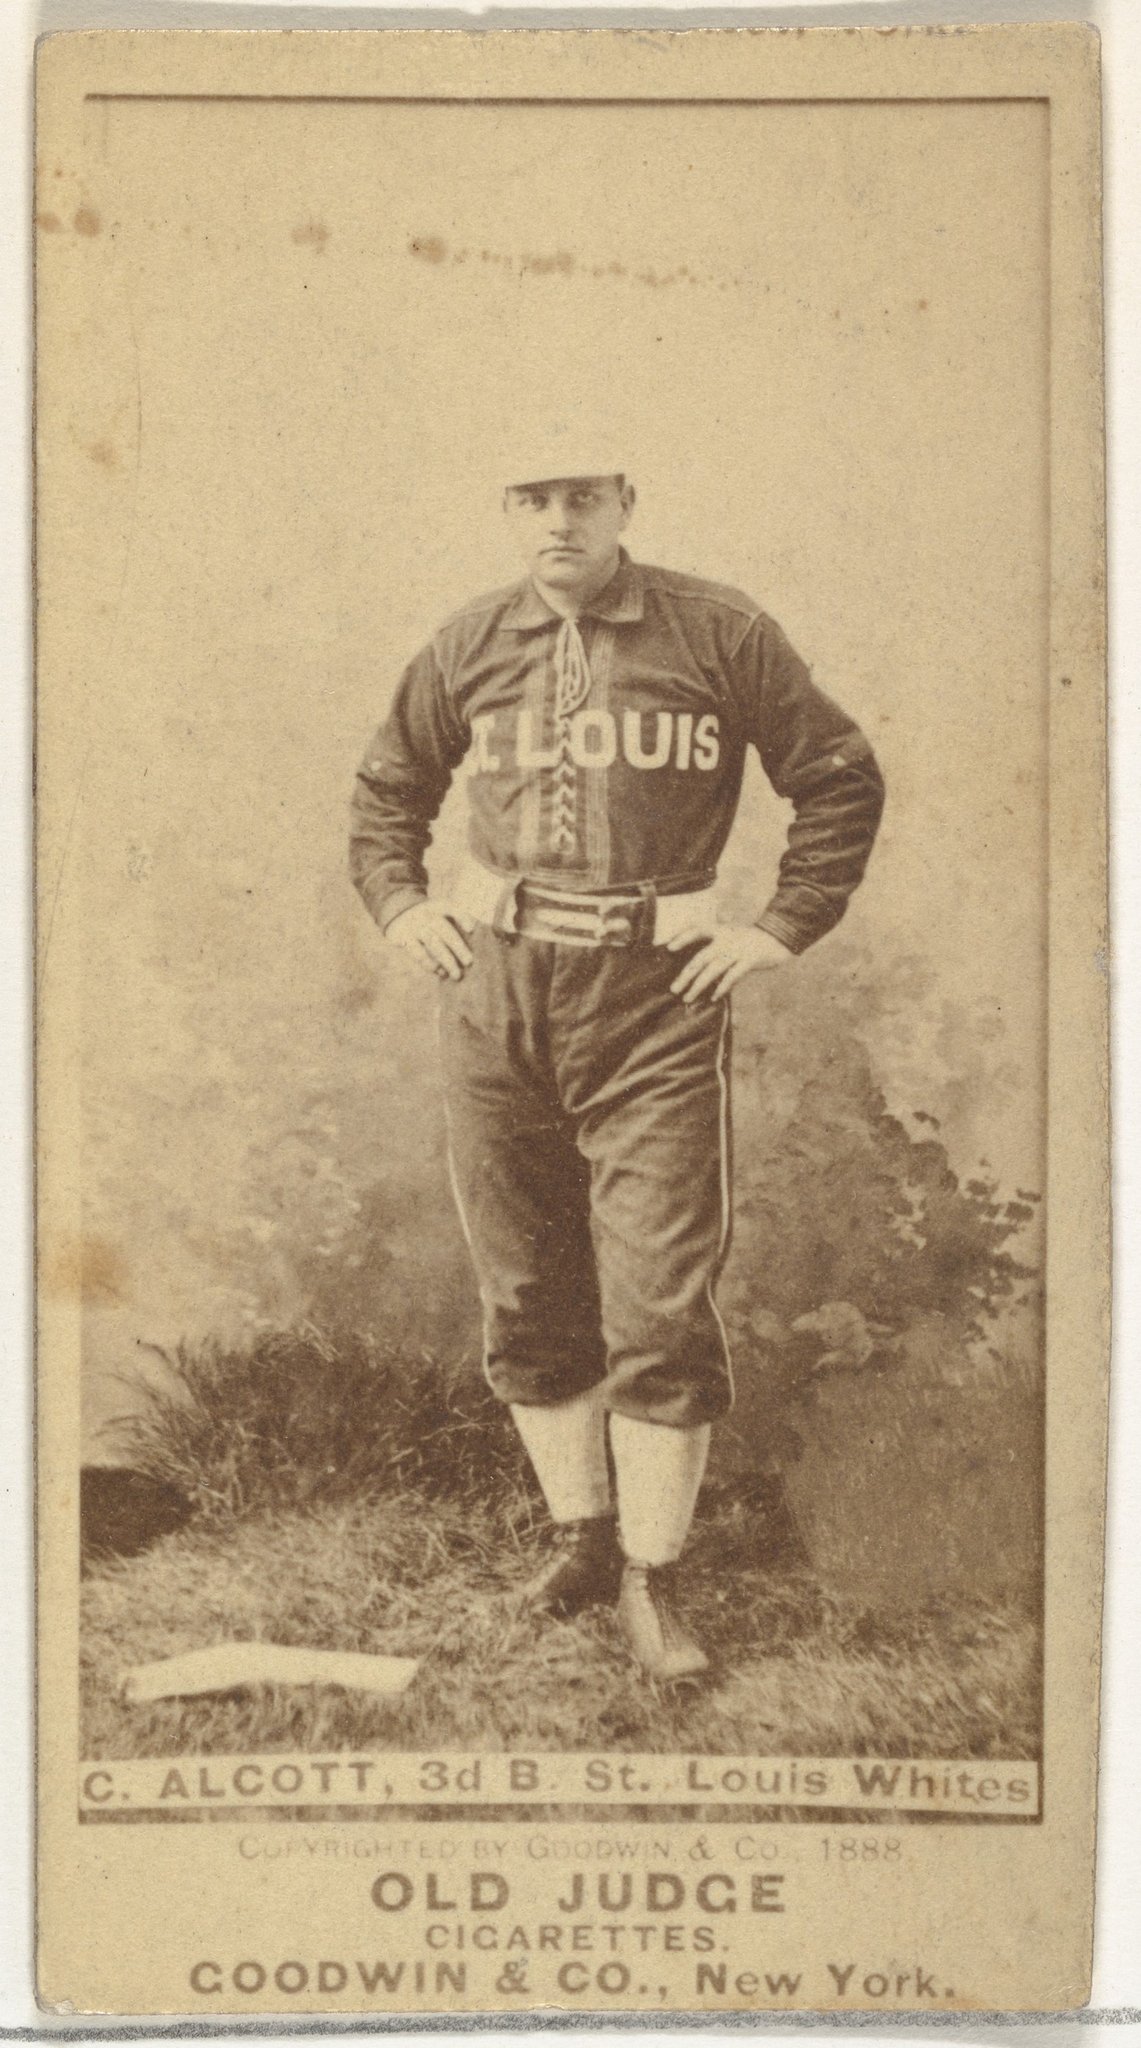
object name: baseball card, photograph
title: Alcott, 3rd Base, St. Louis Whites, from the Old Judge series (N172) for Old Judge Cigarettes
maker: goodwin & company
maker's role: publisher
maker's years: 1850-1950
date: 1888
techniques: albumen silver print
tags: men,portraits,baseball,athletes